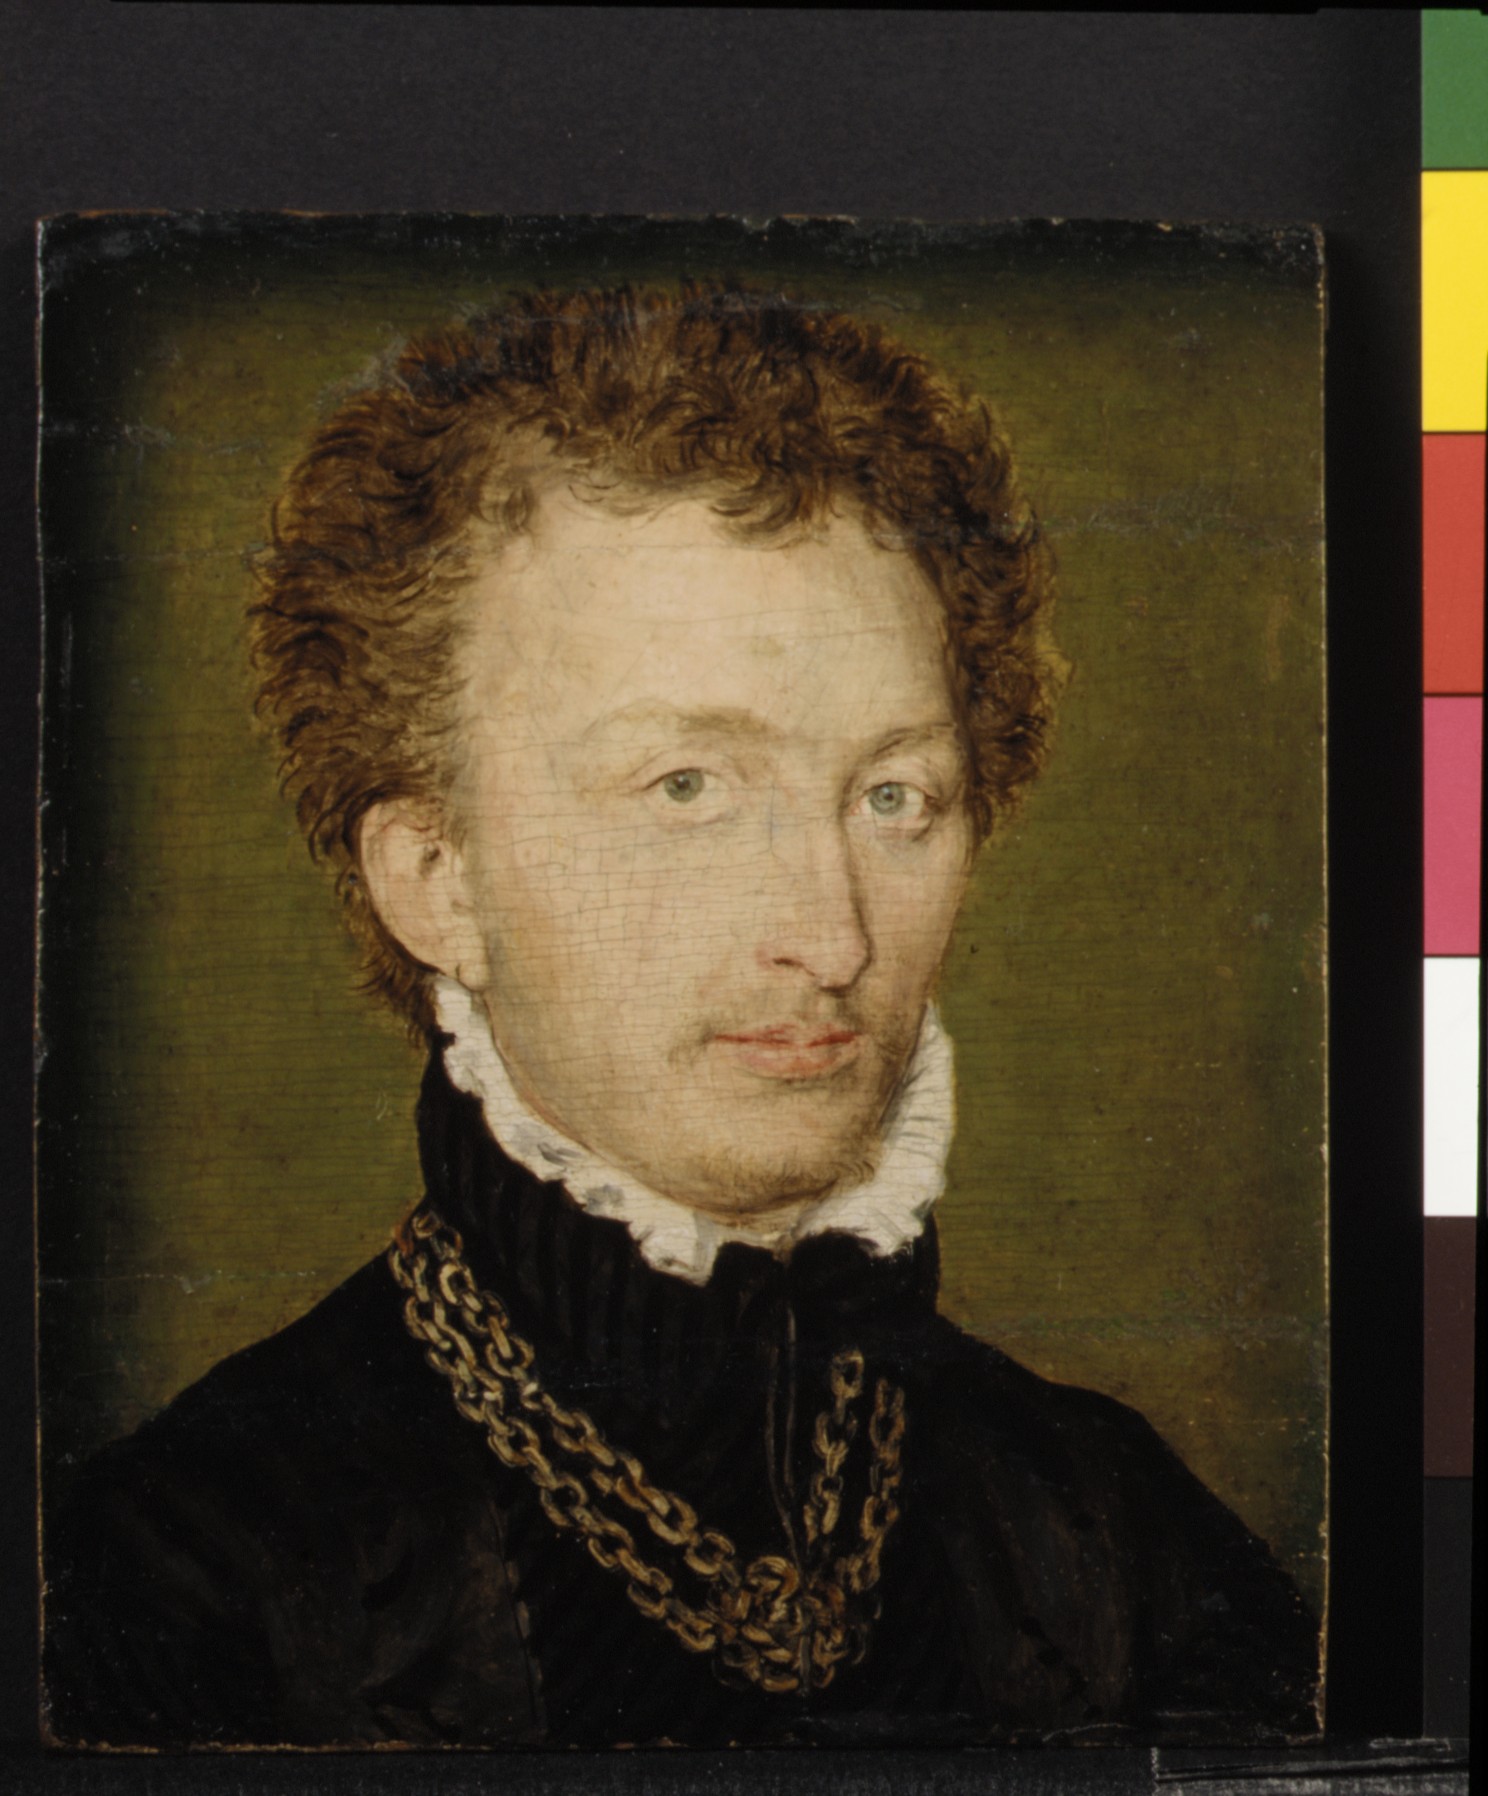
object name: painting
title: Portrait of a Man with a Gold Chain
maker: corneille de lyon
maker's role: artist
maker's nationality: netherlandish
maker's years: 1533-1575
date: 1533-1575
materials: oil, wood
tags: men,portraits